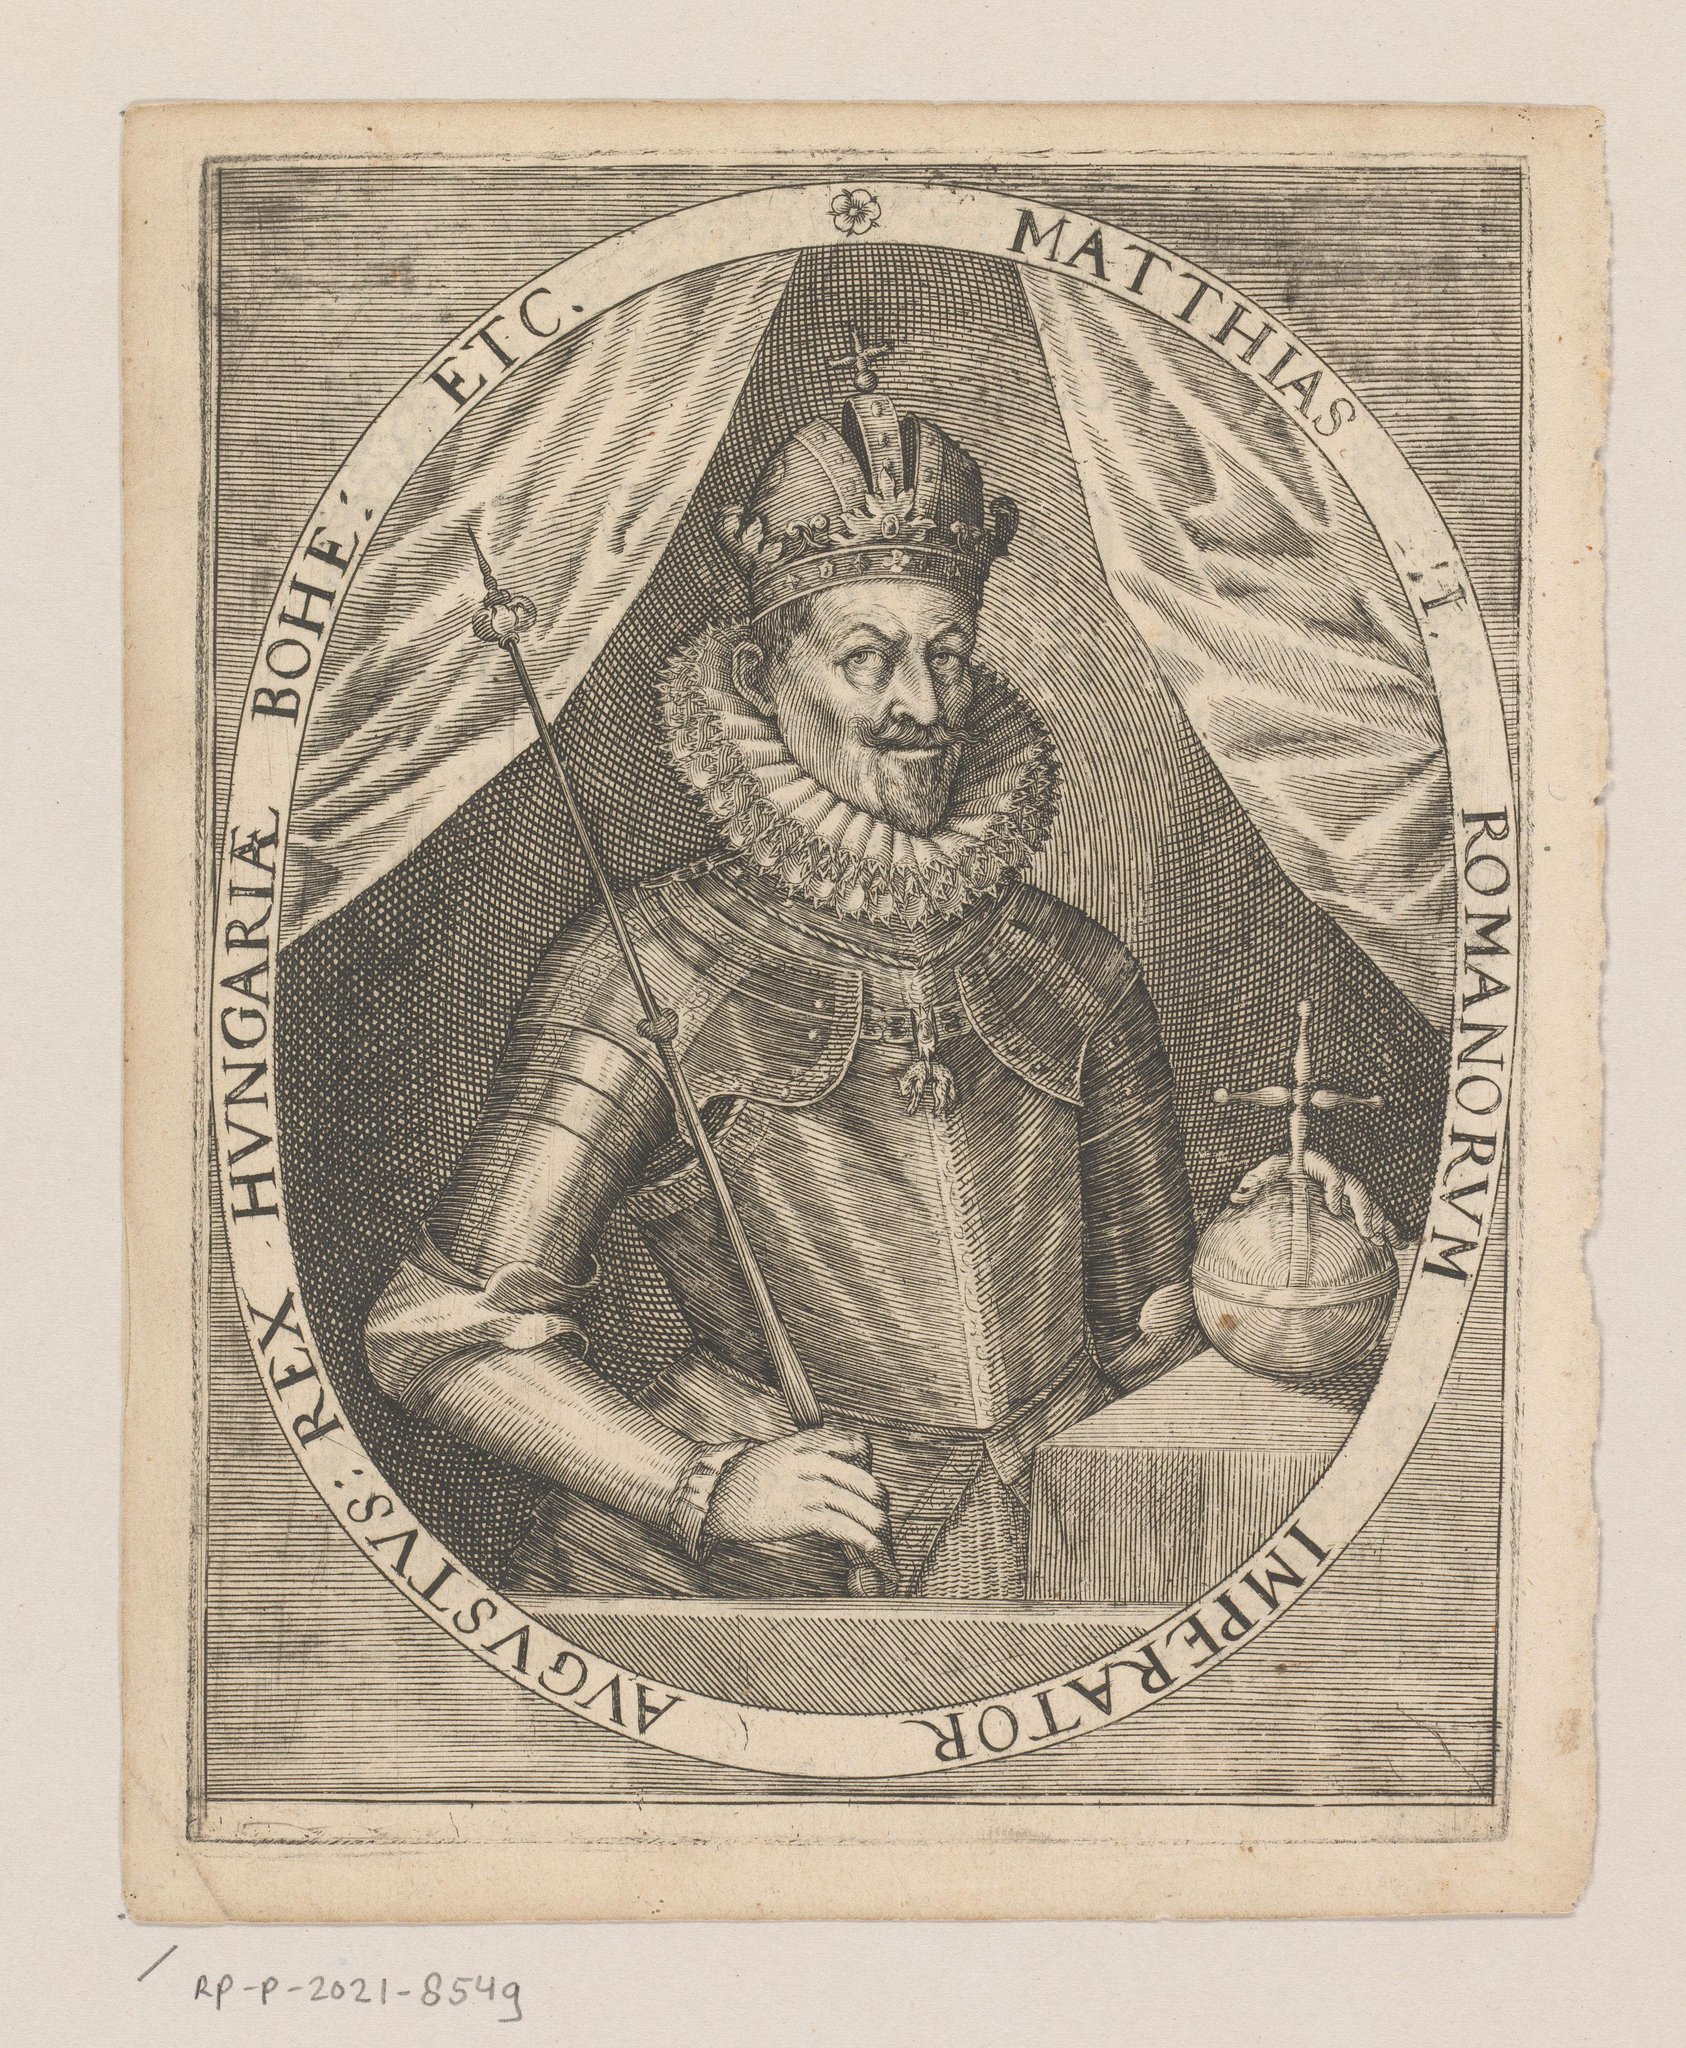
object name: print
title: Portret van keizer Matthias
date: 1622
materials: paper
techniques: engraving, letterpress printing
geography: northern netherlands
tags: vienna, matthias van oostenrijk (rooms-duits keizer), ornament ~ medallion, historical persons, knighthood order of the golden fleece, emperor, insignia and symbols of sovereignty (crown, diadem, sceptre, orb, seal, standard, cloak, pectoral)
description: Op het verso de titelpagina van: Oertel, Hieronymus. Appendix partis quartae Chronologiae Ungaricae, das ist; warhafftige ausführliche historische Beschreibung (...). Neurenberg: Wolfgang Endter, 1622.